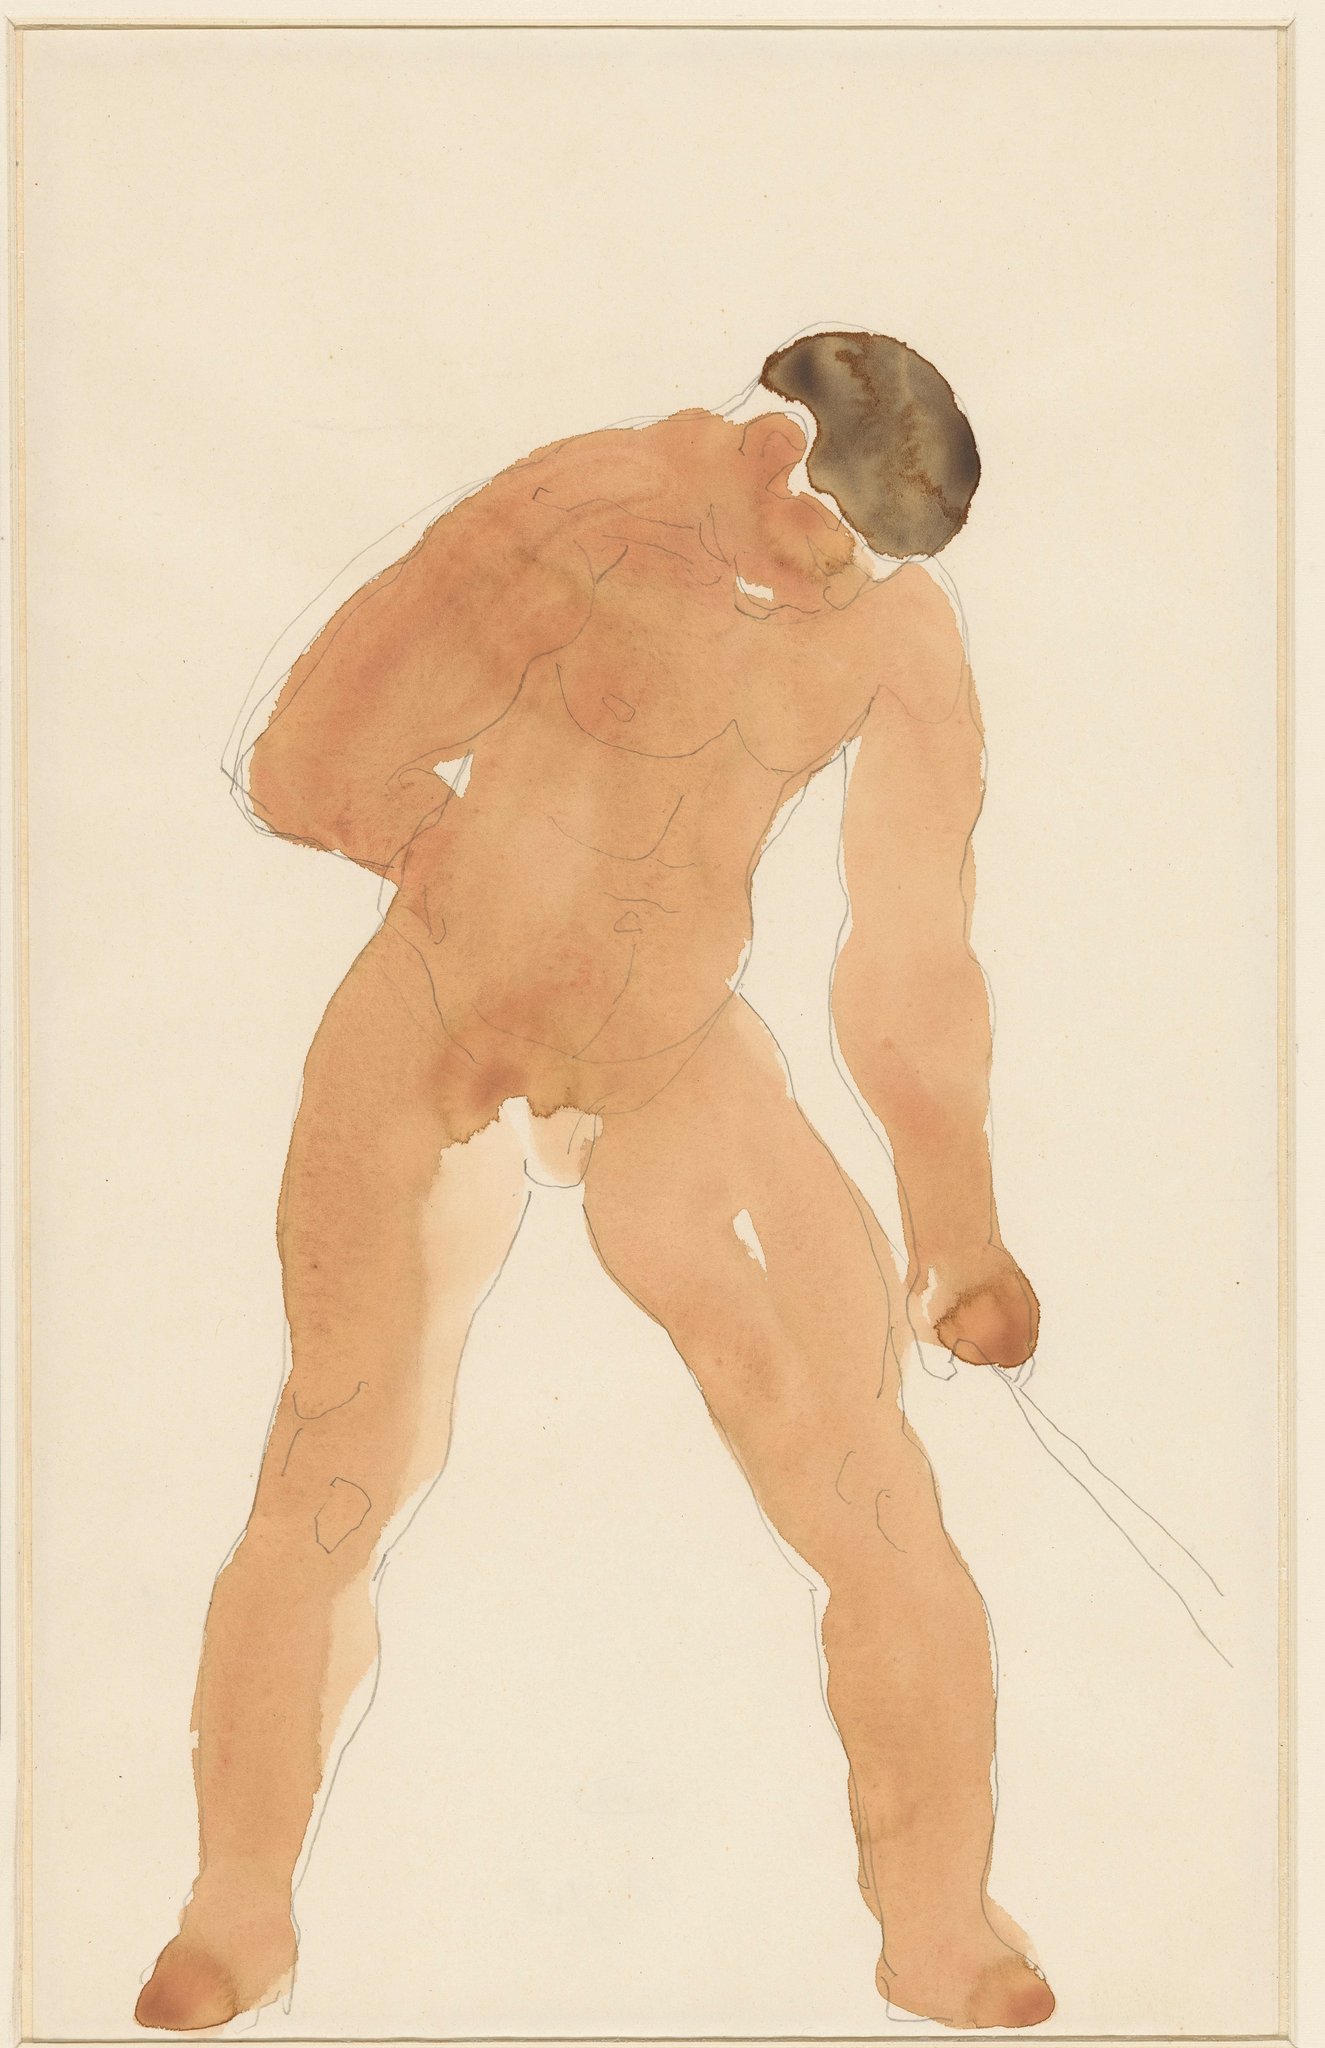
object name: drawing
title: Staande naakte man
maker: reijer stolk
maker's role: draughtsman, print maker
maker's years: 1896-1945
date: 1906-1945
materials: ink, paper, pencil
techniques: brush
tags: standing figure (canon, proportions)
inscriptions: collector's mark: Lugt 2228